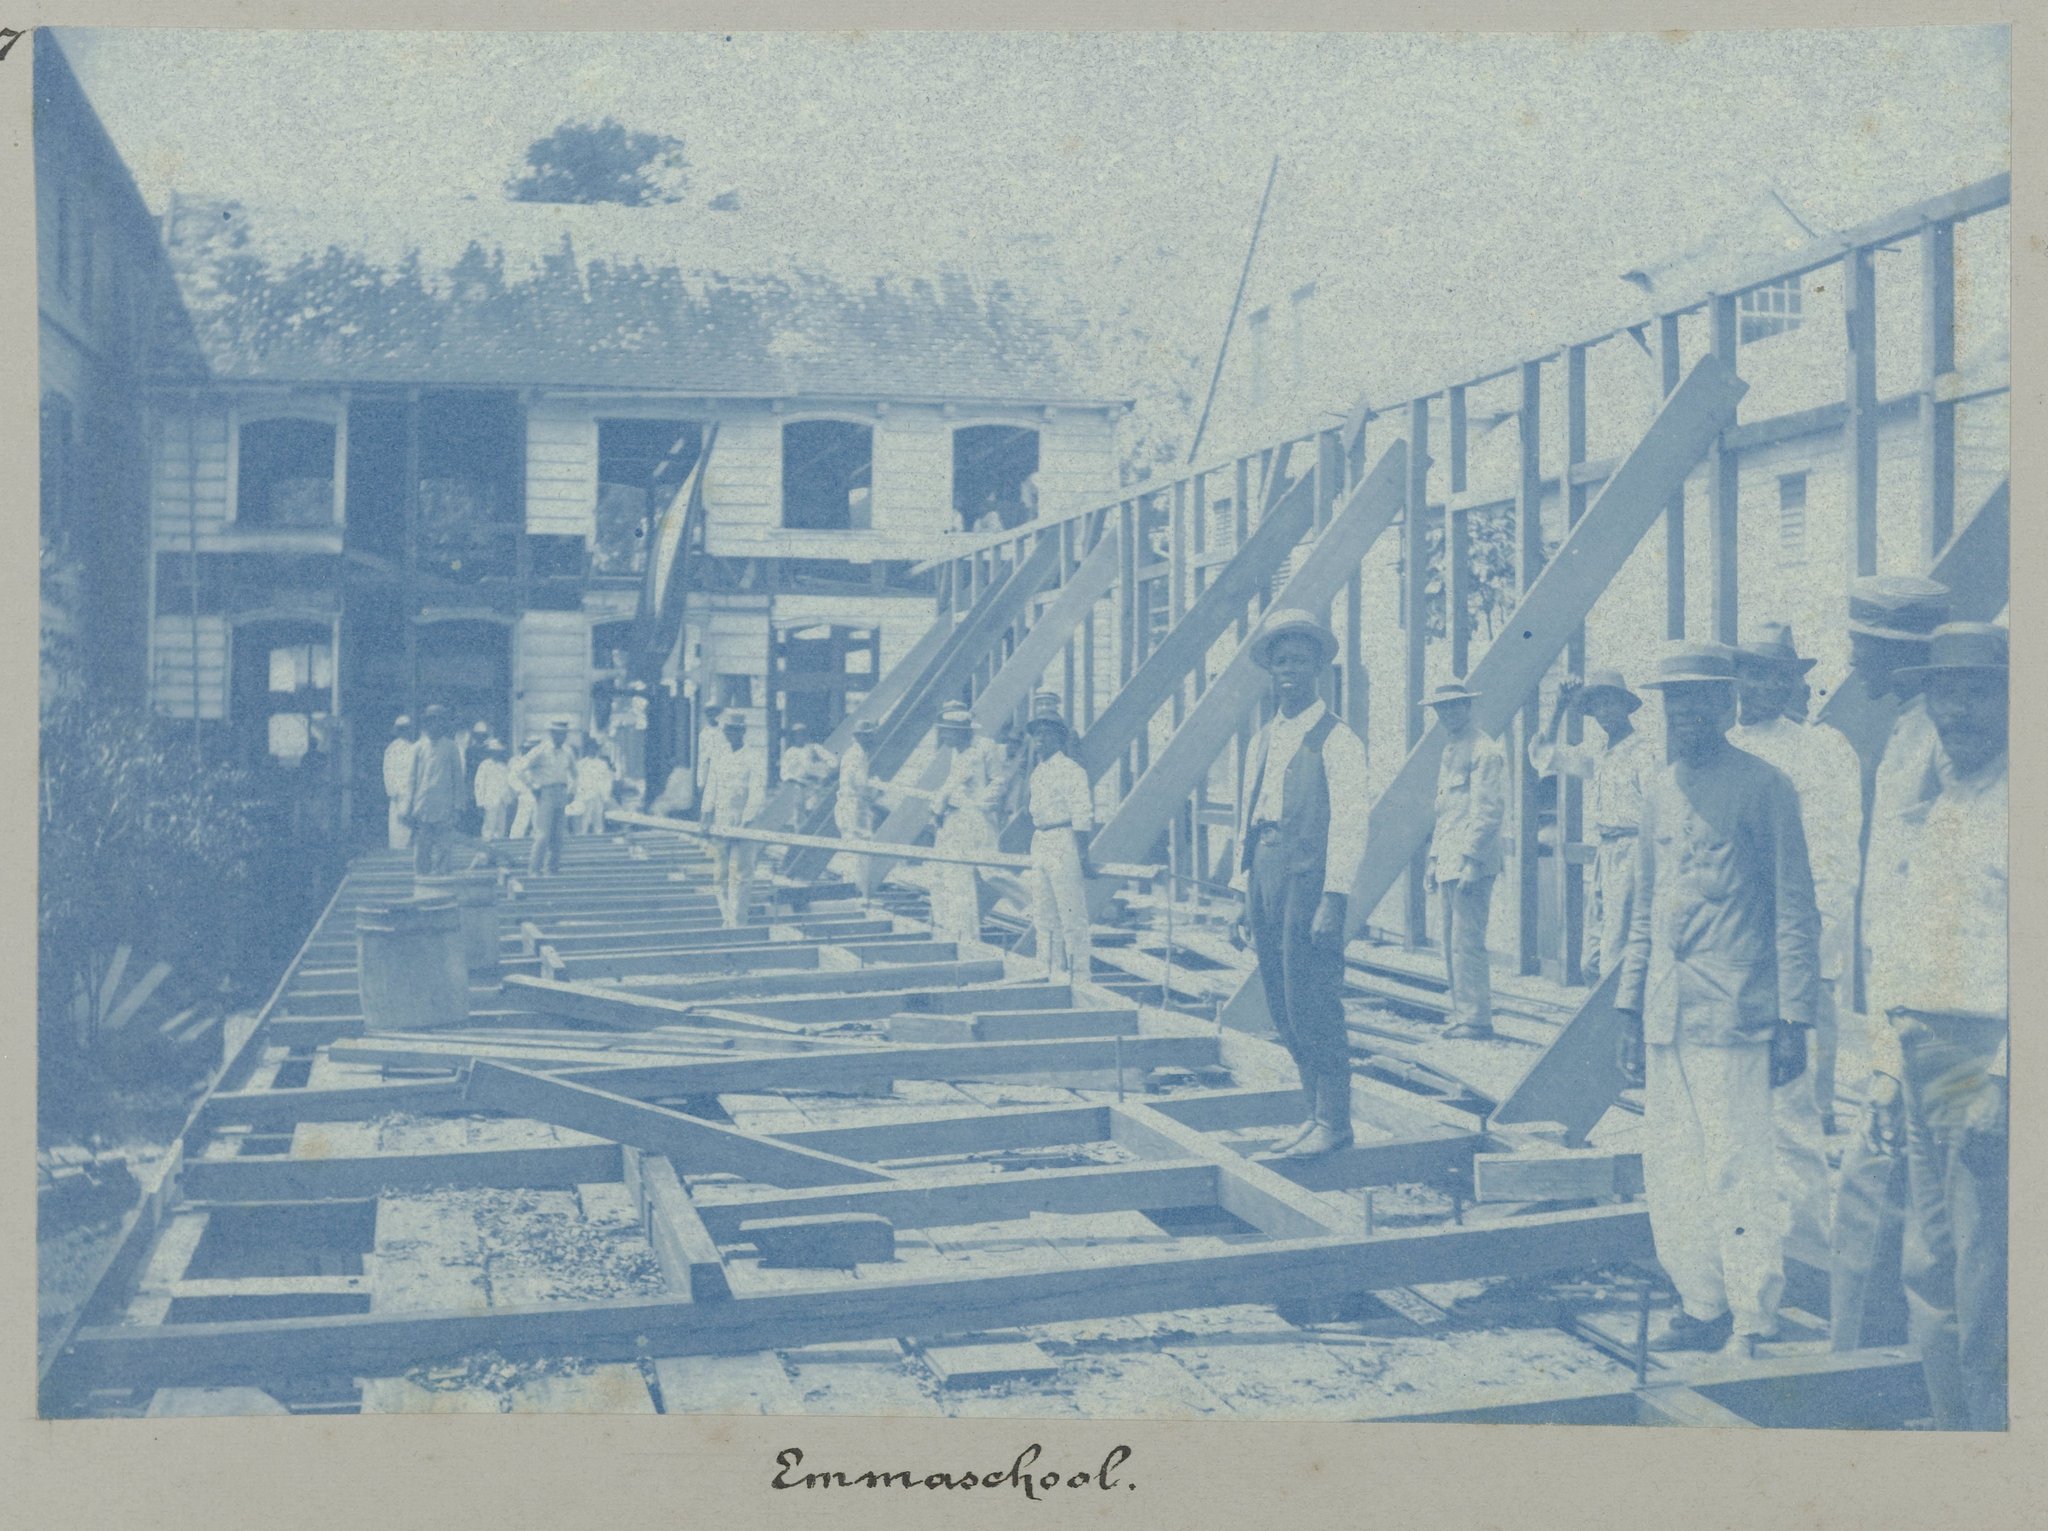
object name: photograph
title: Emmaschool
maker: hendrik doijer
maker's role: engineer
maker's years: 1863-1925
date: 1903-1910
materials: photographic support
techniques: cyanotype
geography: suriname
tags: suriname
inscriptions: inscription: ‘E7 / Emmaschool.’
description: De Emmaschool te Paramaribo in aanbouw, interieurgezicht met bouwvakkers die staan klaar om muurdelen op te rechten. Onderdeel van het fotoalbum Souvenir de Voyage (deel 4), over het leven van de familie Doijer in en rond de plantage Ma Retraite in Suriname in de jaren 1903-1910.